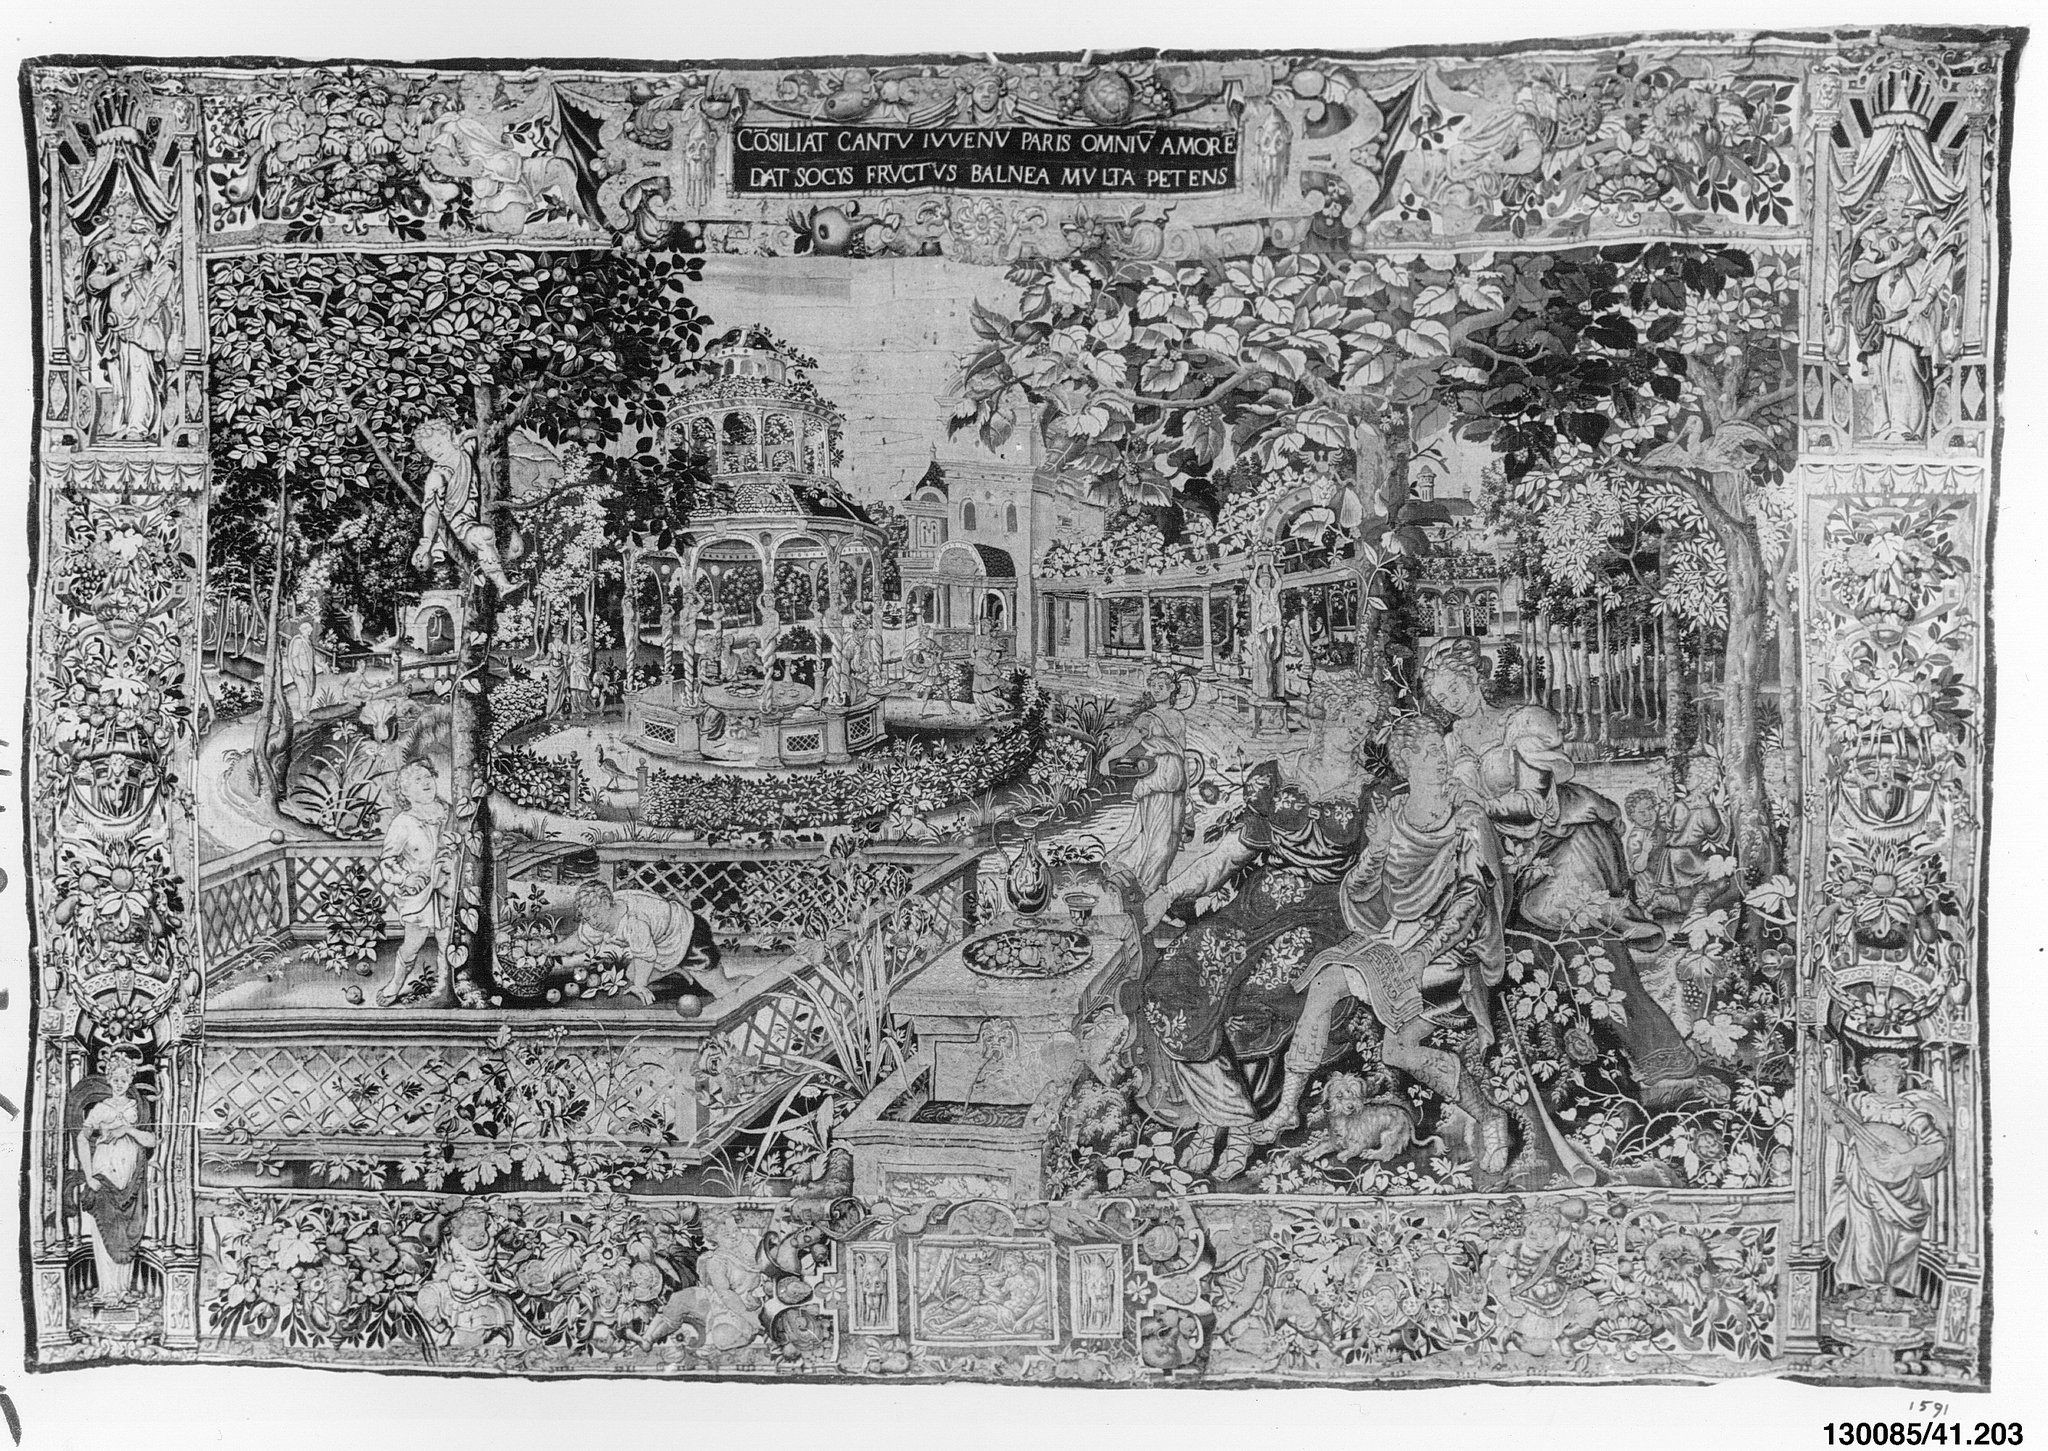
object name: tapestry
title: Paris as a Youth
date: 1560-1580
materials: silk, wool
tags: gardens,children,men,women,paris